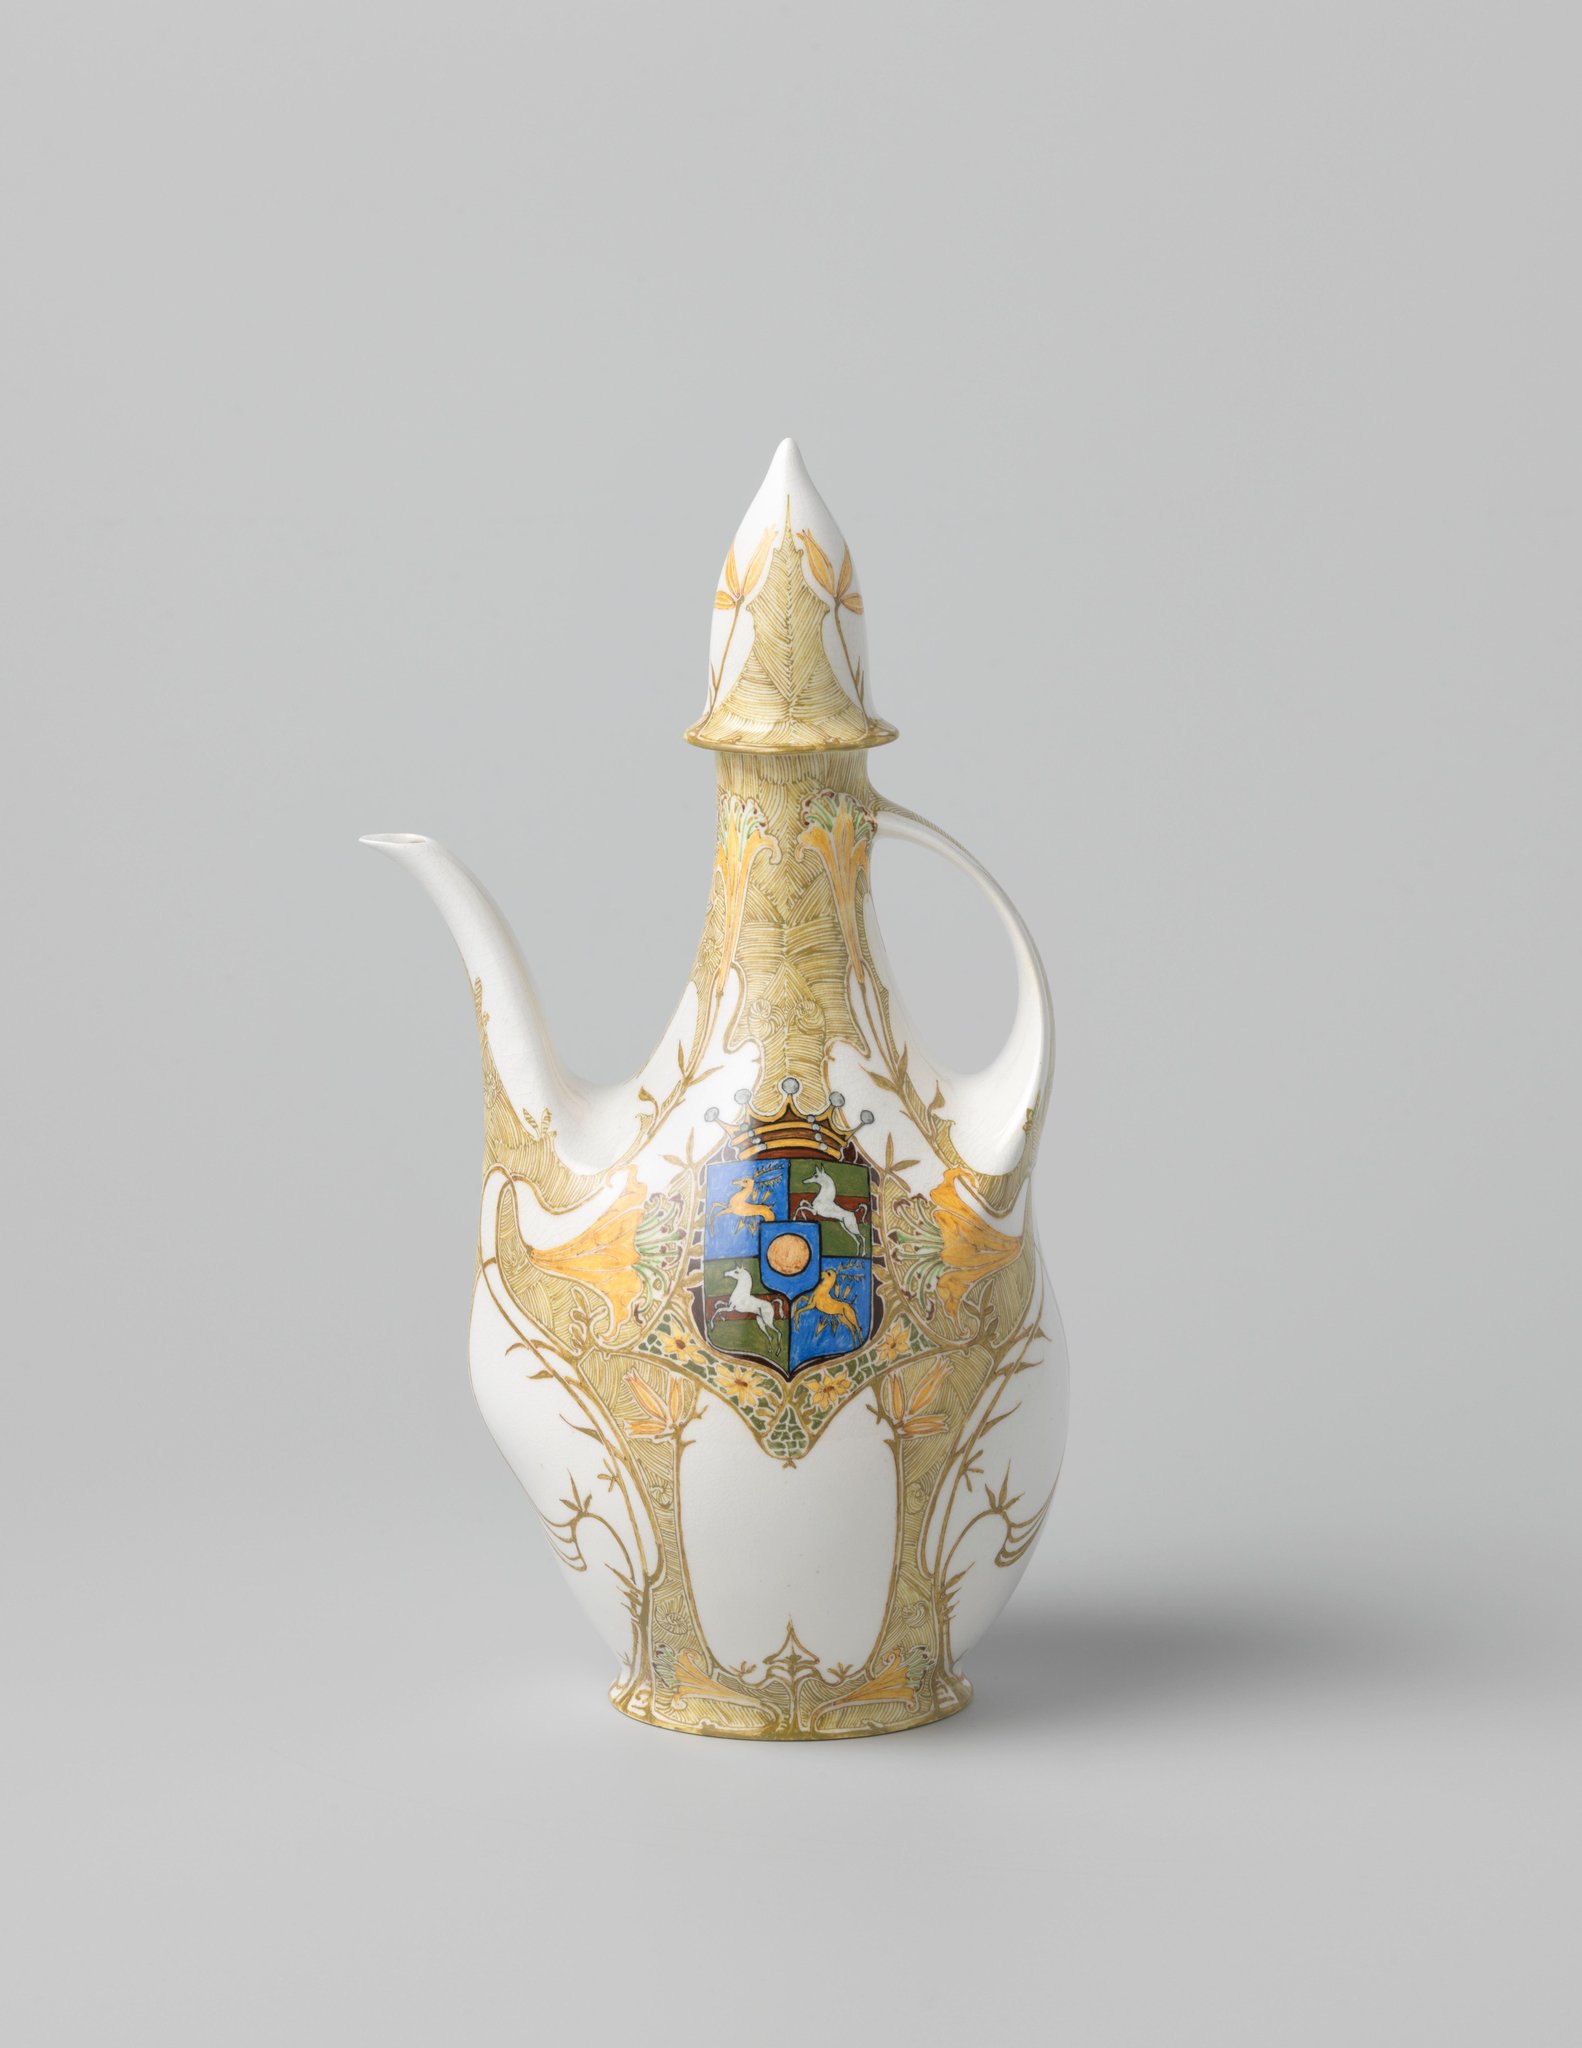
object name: teapot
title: Theepot met deksel, deel van een tête-à-tête, beschilderd met lelies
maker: jacob willem van rossum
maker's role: print maker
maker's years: 1881-1963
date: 1900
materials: porcelain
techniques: painted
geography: the hague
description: Theepot met deksel van een tête-à-tête van porselein. Beschilderd in geel, roodbruin en verschillende tinten groen met een ornamentaal decor, waarin lelies. Op alle delen het monogram MvV (= Michiels van Verduynen) en het wapen van deze familie, waarin ook nog de kleur blauw voorkomt. Gemerkt Rozenburg.